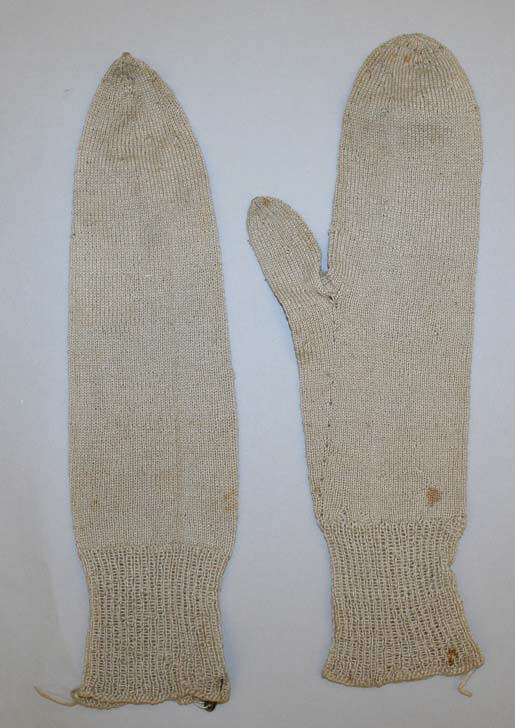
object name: mitten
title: Mittens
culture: american or european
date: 1801-1900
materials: wool